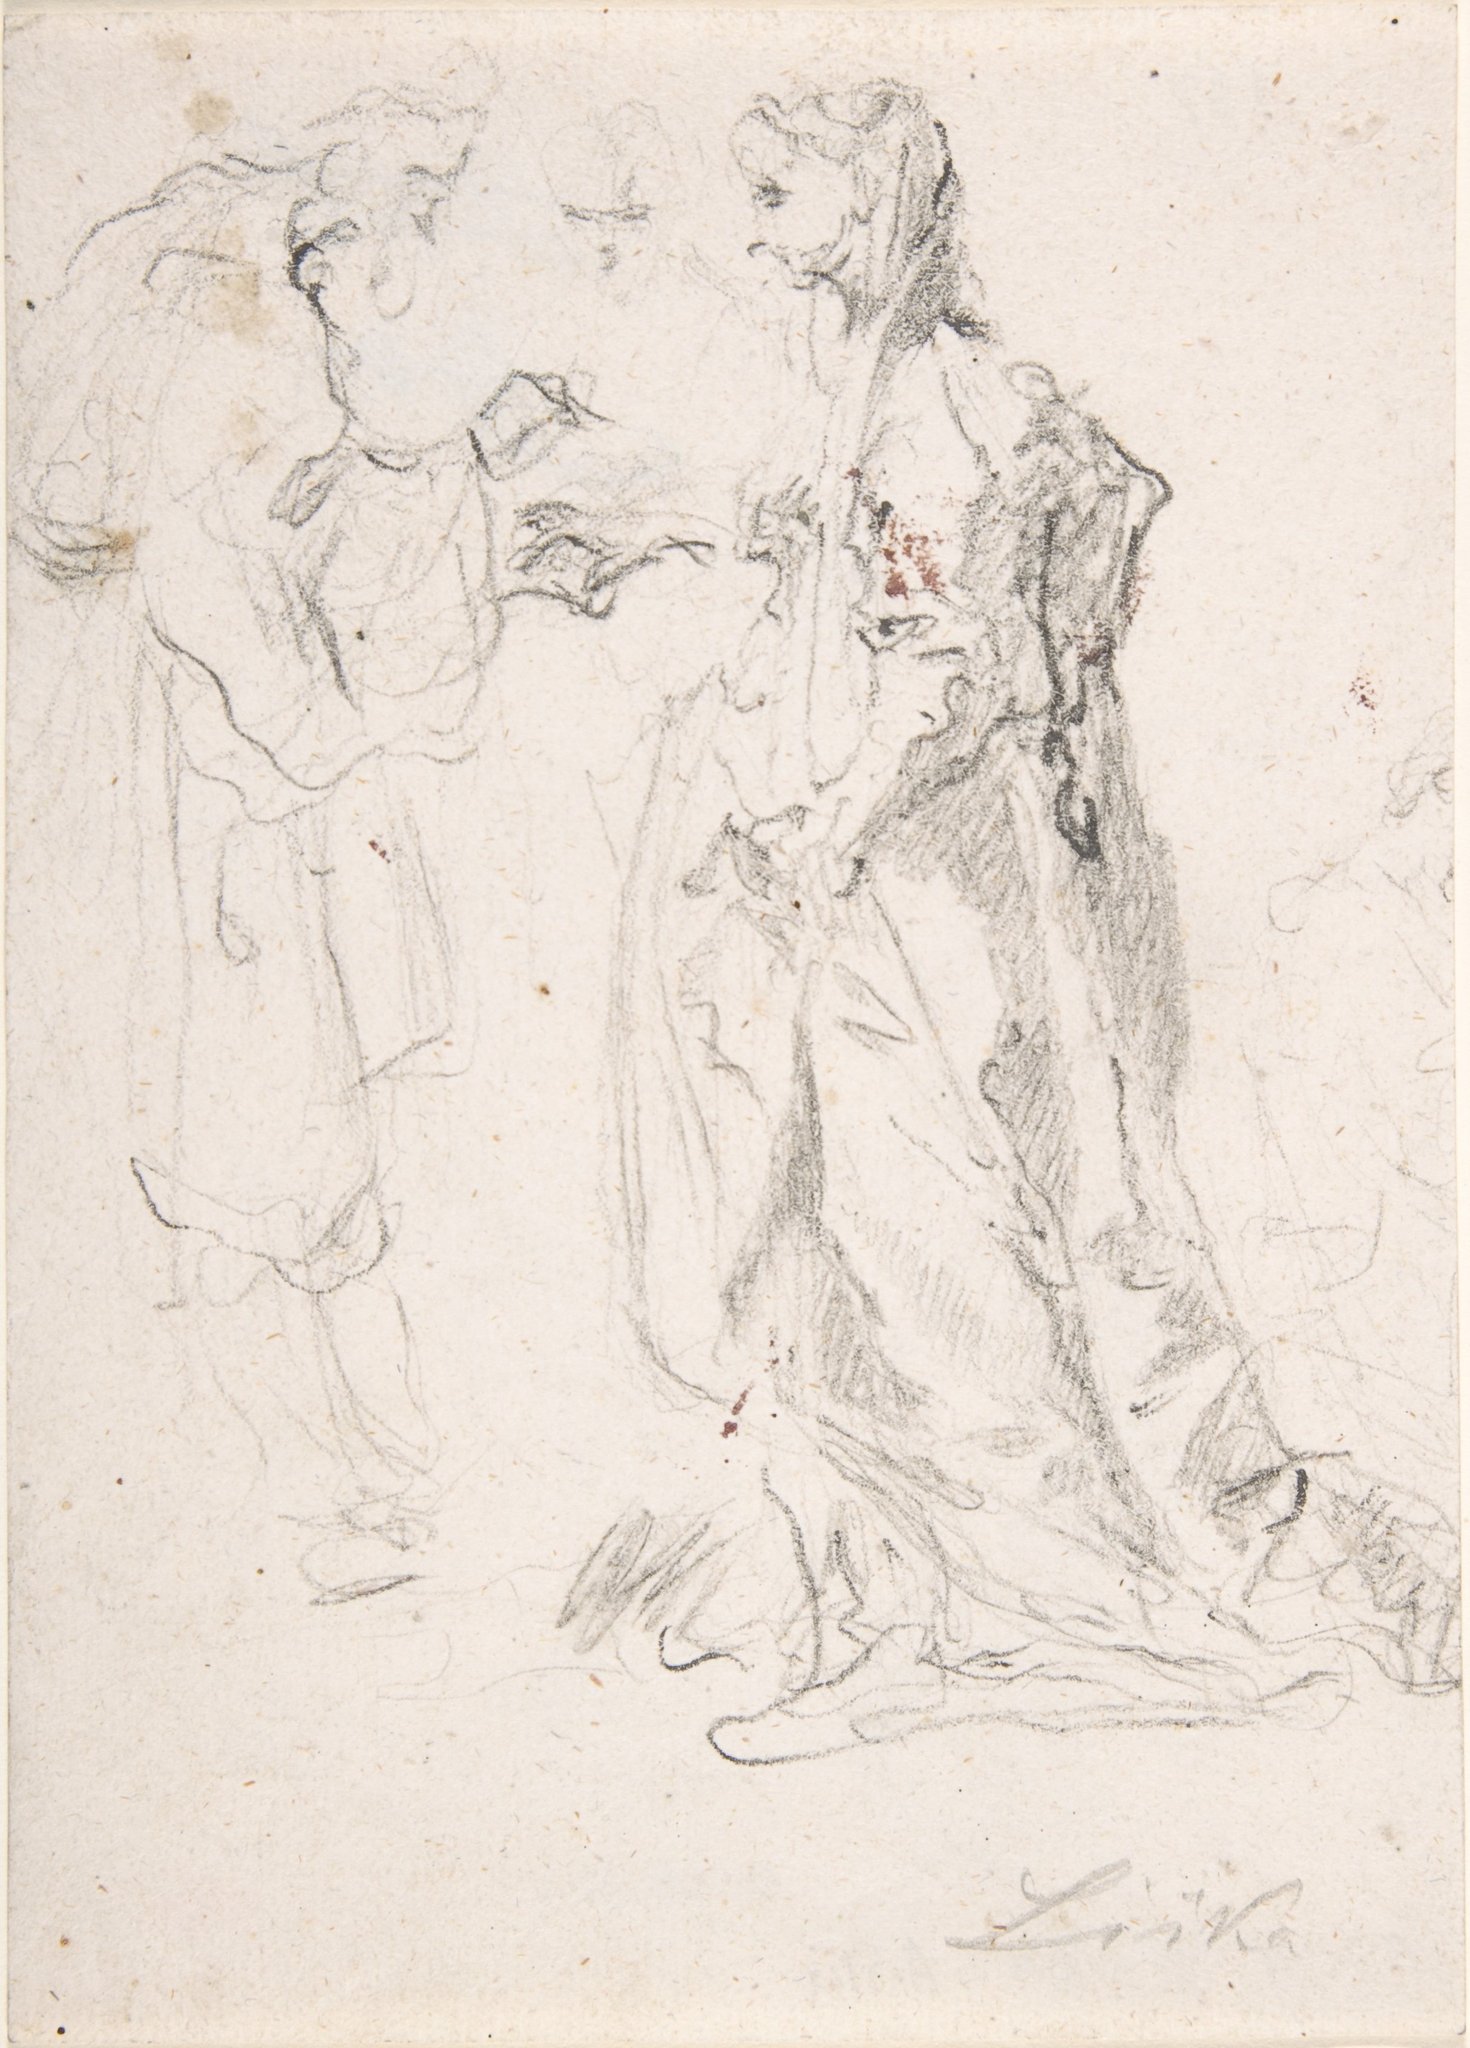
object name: drawing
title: A Man Holding the Hand of a Woman, Another Woman Looking On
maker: johann christoph liska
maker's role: artist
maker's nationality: german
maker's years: 1650-1712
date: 1667-1733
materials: chalk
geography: germany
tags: men,women